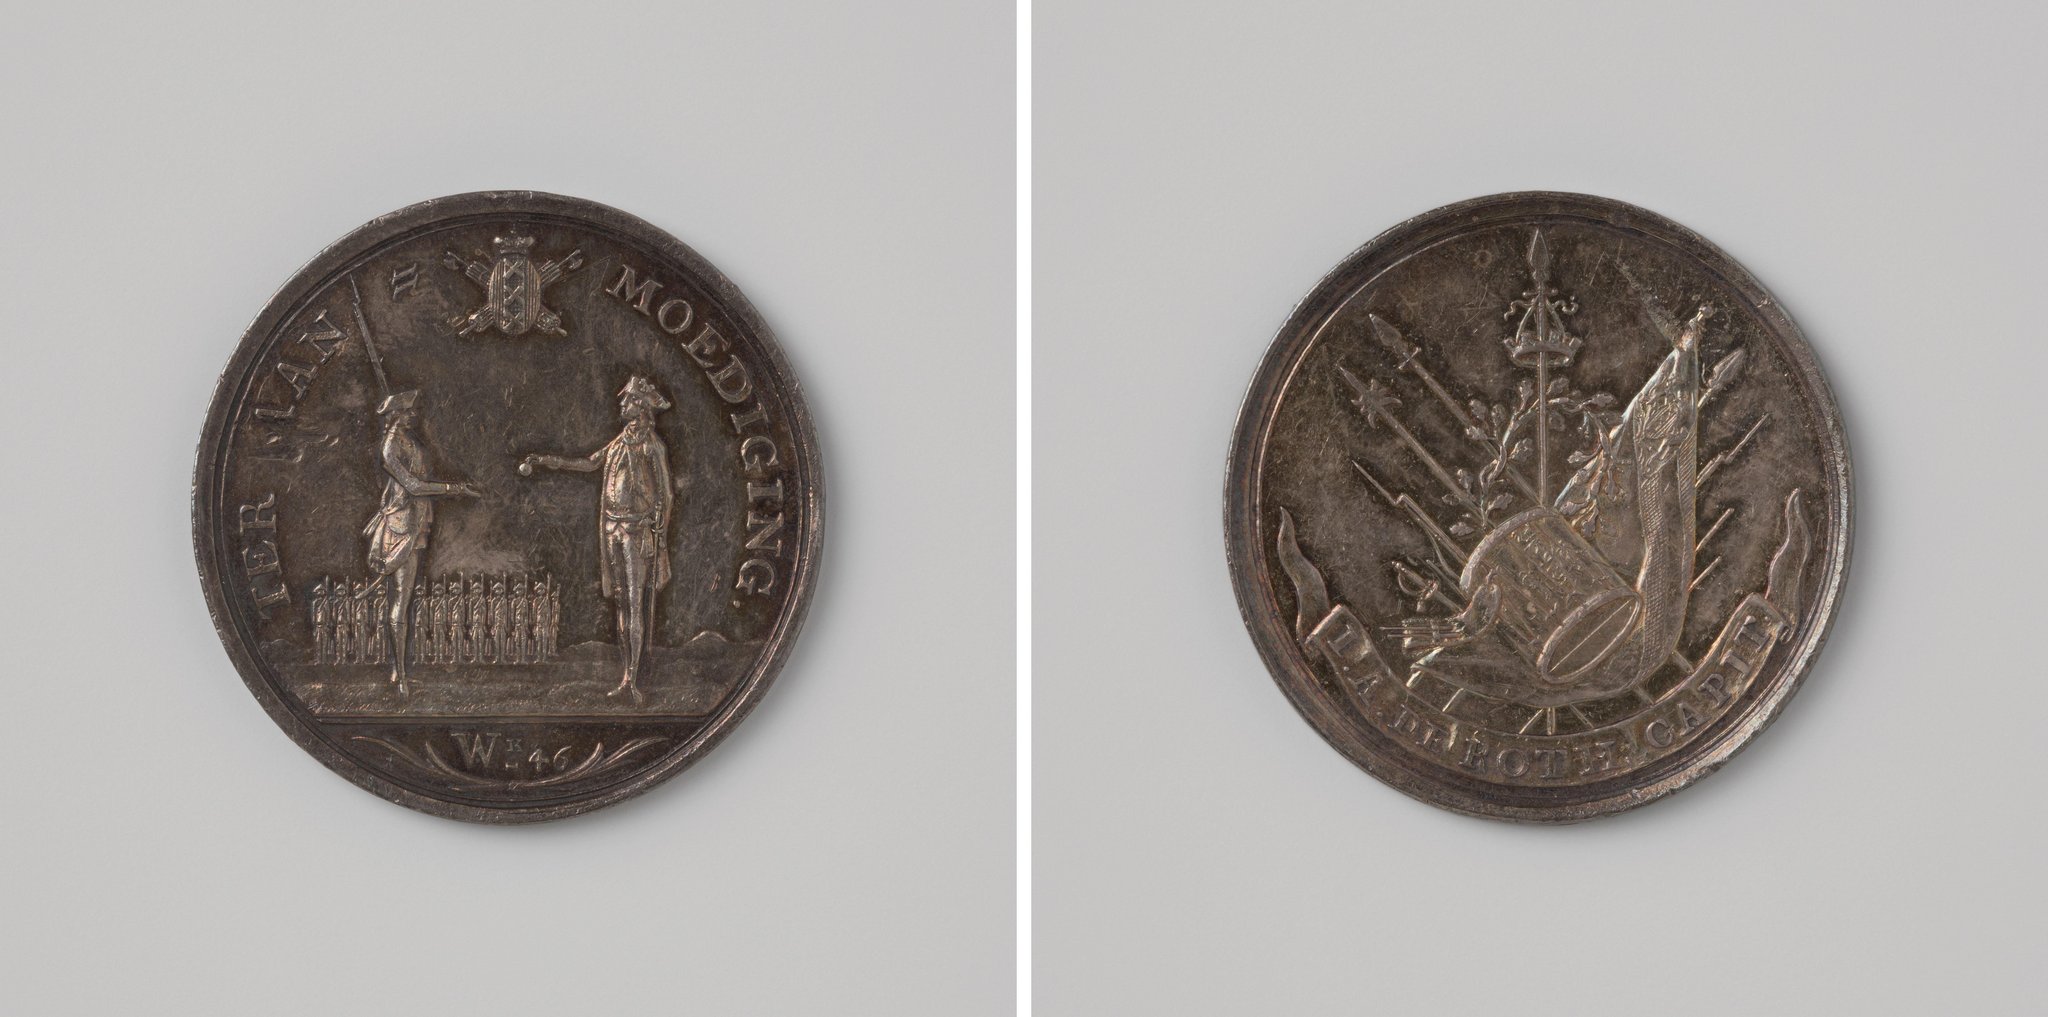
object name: history medal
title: De schutterijcompagnie van wijk 46 tot wapenoefening aangespoord, penning door kapitein Jacob Anthony de Roth aan alle manschappen uitgedeeld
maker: johan george holtzhey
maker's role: mintmaster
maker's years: 1726-1808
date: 1783-1784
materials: silver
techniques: striking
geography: amsterdam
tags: suratte, baarn, jacob anthony de roth